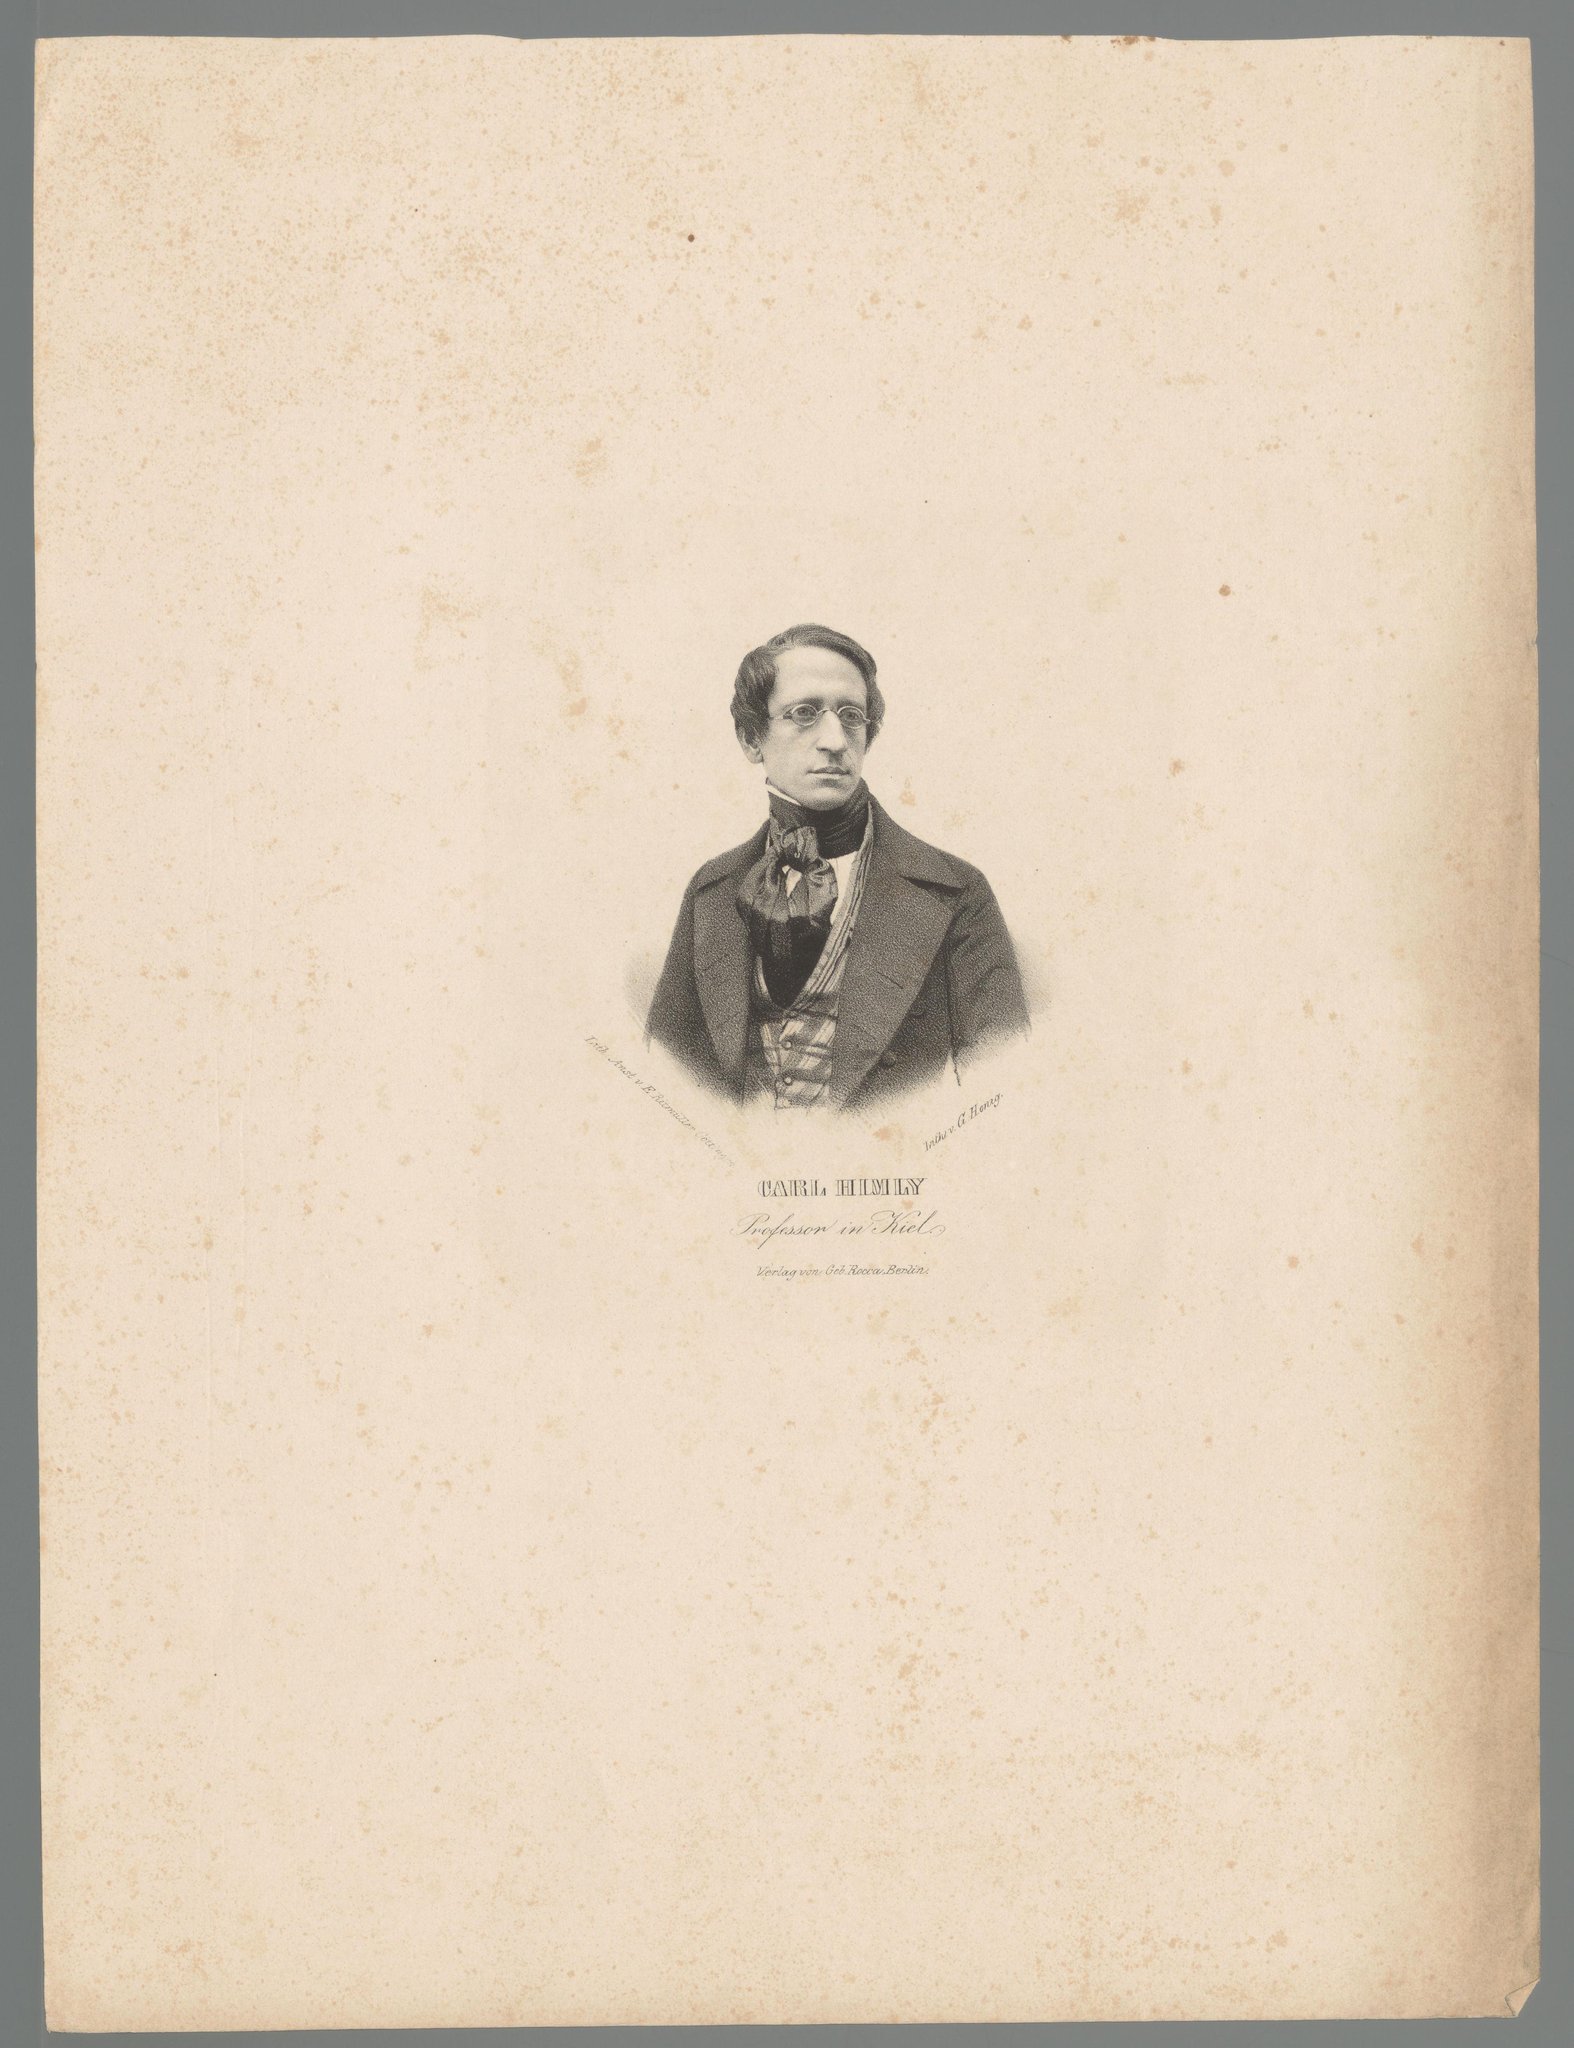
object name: print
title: Carl Himly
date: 1835-1875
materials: paper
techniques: lithograph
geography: berlin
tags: eyeglasses, spectacles, adult man, historical persons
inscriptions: collector's mark: Lugt 2228